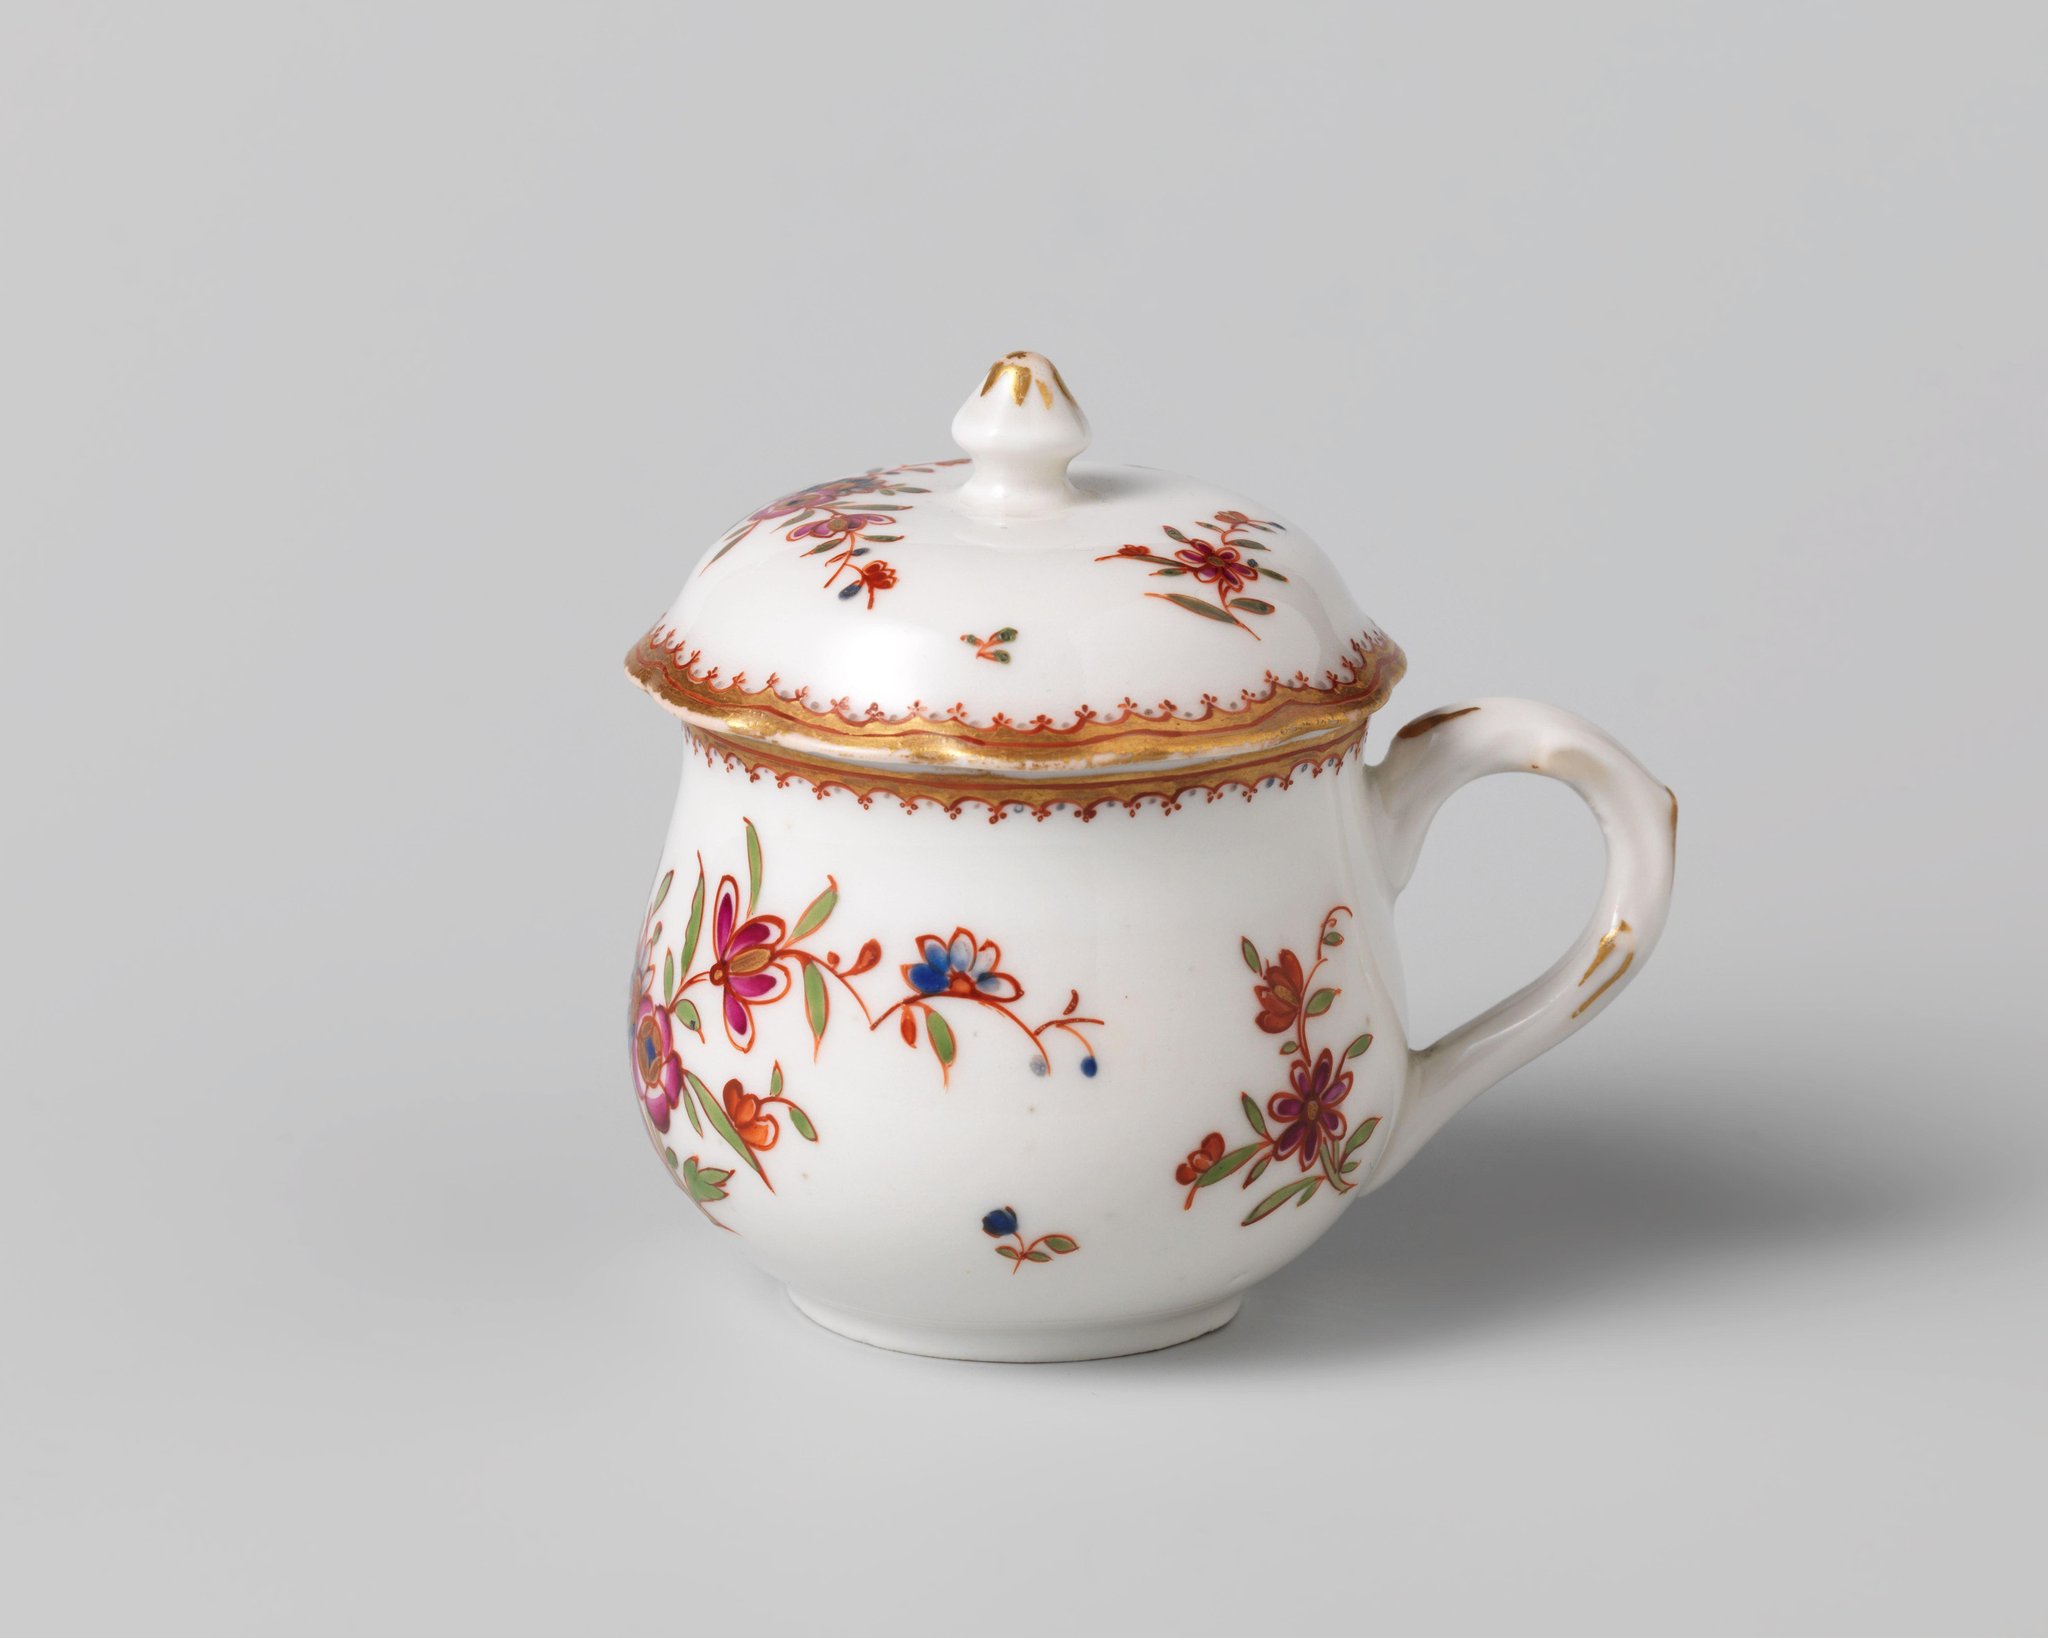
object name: crèmepot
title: Crèmepot, beschilderd met 'Indianische Blumen'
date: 1778-1782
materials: porcelain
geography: loosdrecht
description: Crèmepot van porselein. Met oor in de vorm van een takje, gehoogd met goud. Potje en deksel zijn veelkleurig beschilderd met 'lndianische Blumen'. Langs de randen van het potje en het geschulpte deksel een 'Chine de Commande'-randje in rood en goud.